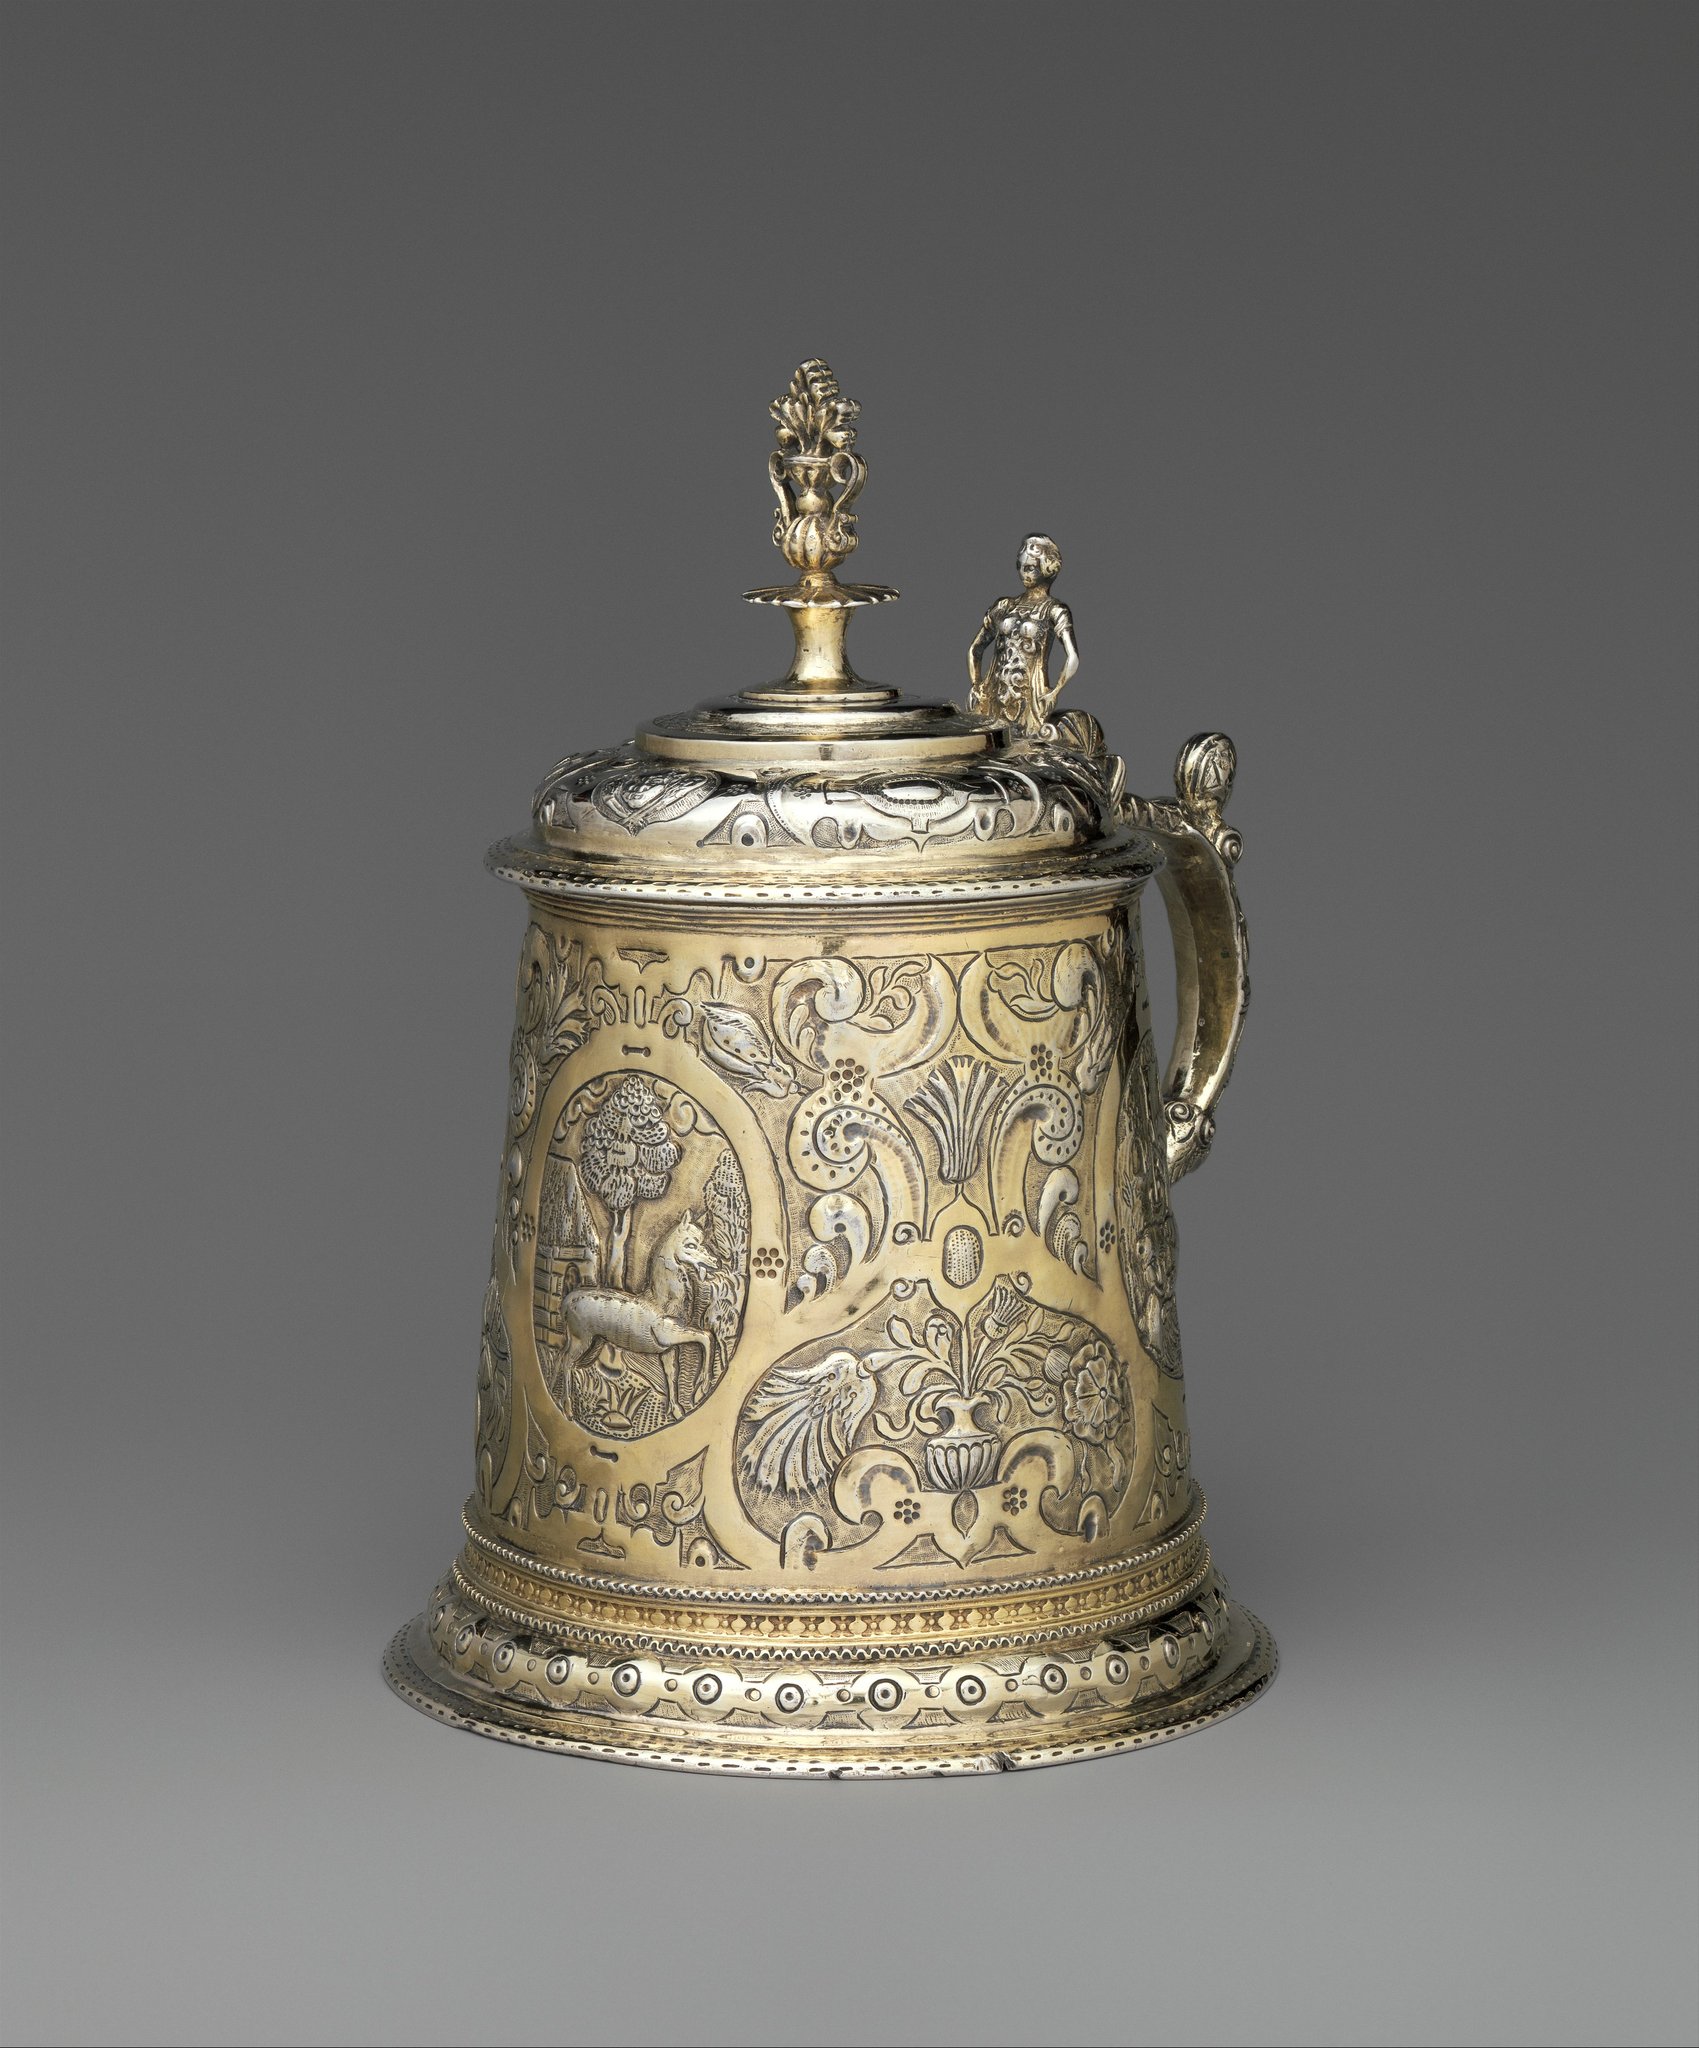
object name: tankard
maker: michael beri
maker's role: maker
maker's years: 1622-1632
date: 1627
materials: gilt silver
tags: human figures,horses